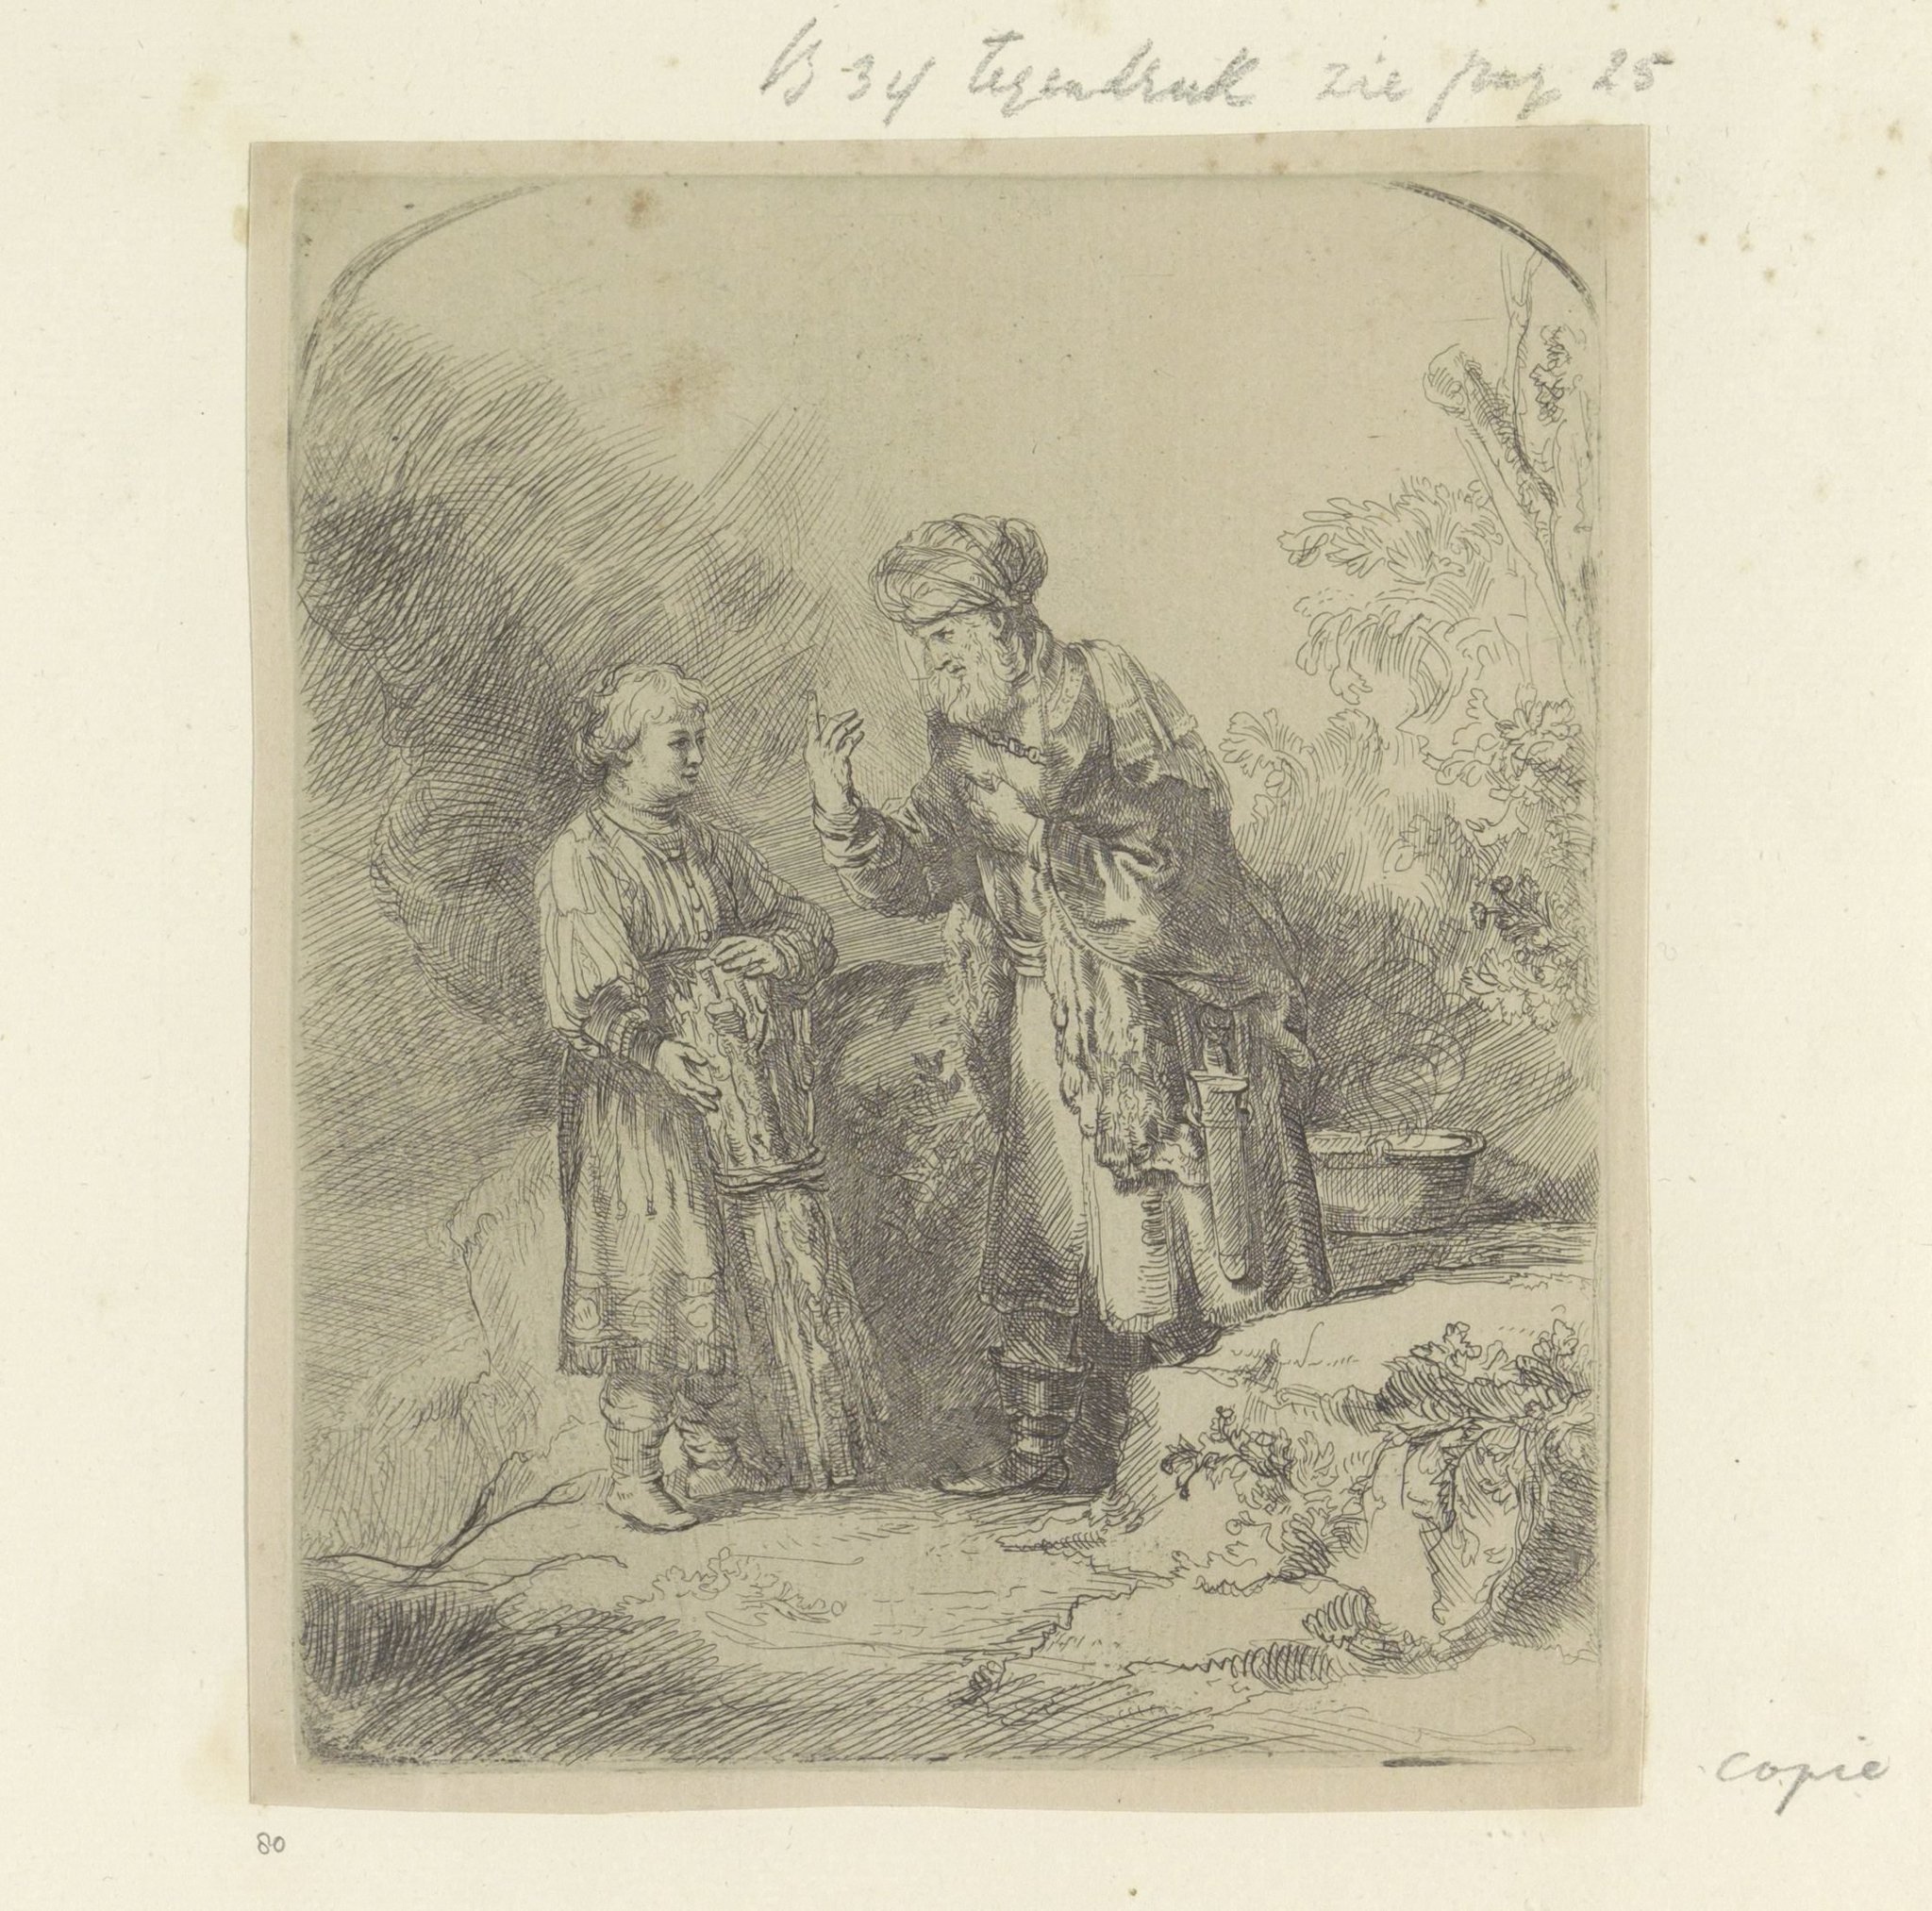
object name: album leaf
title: Abraham en Izaäk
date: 1635-1807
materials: paper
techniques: etching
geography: paris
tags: story of isaac, story of abraham